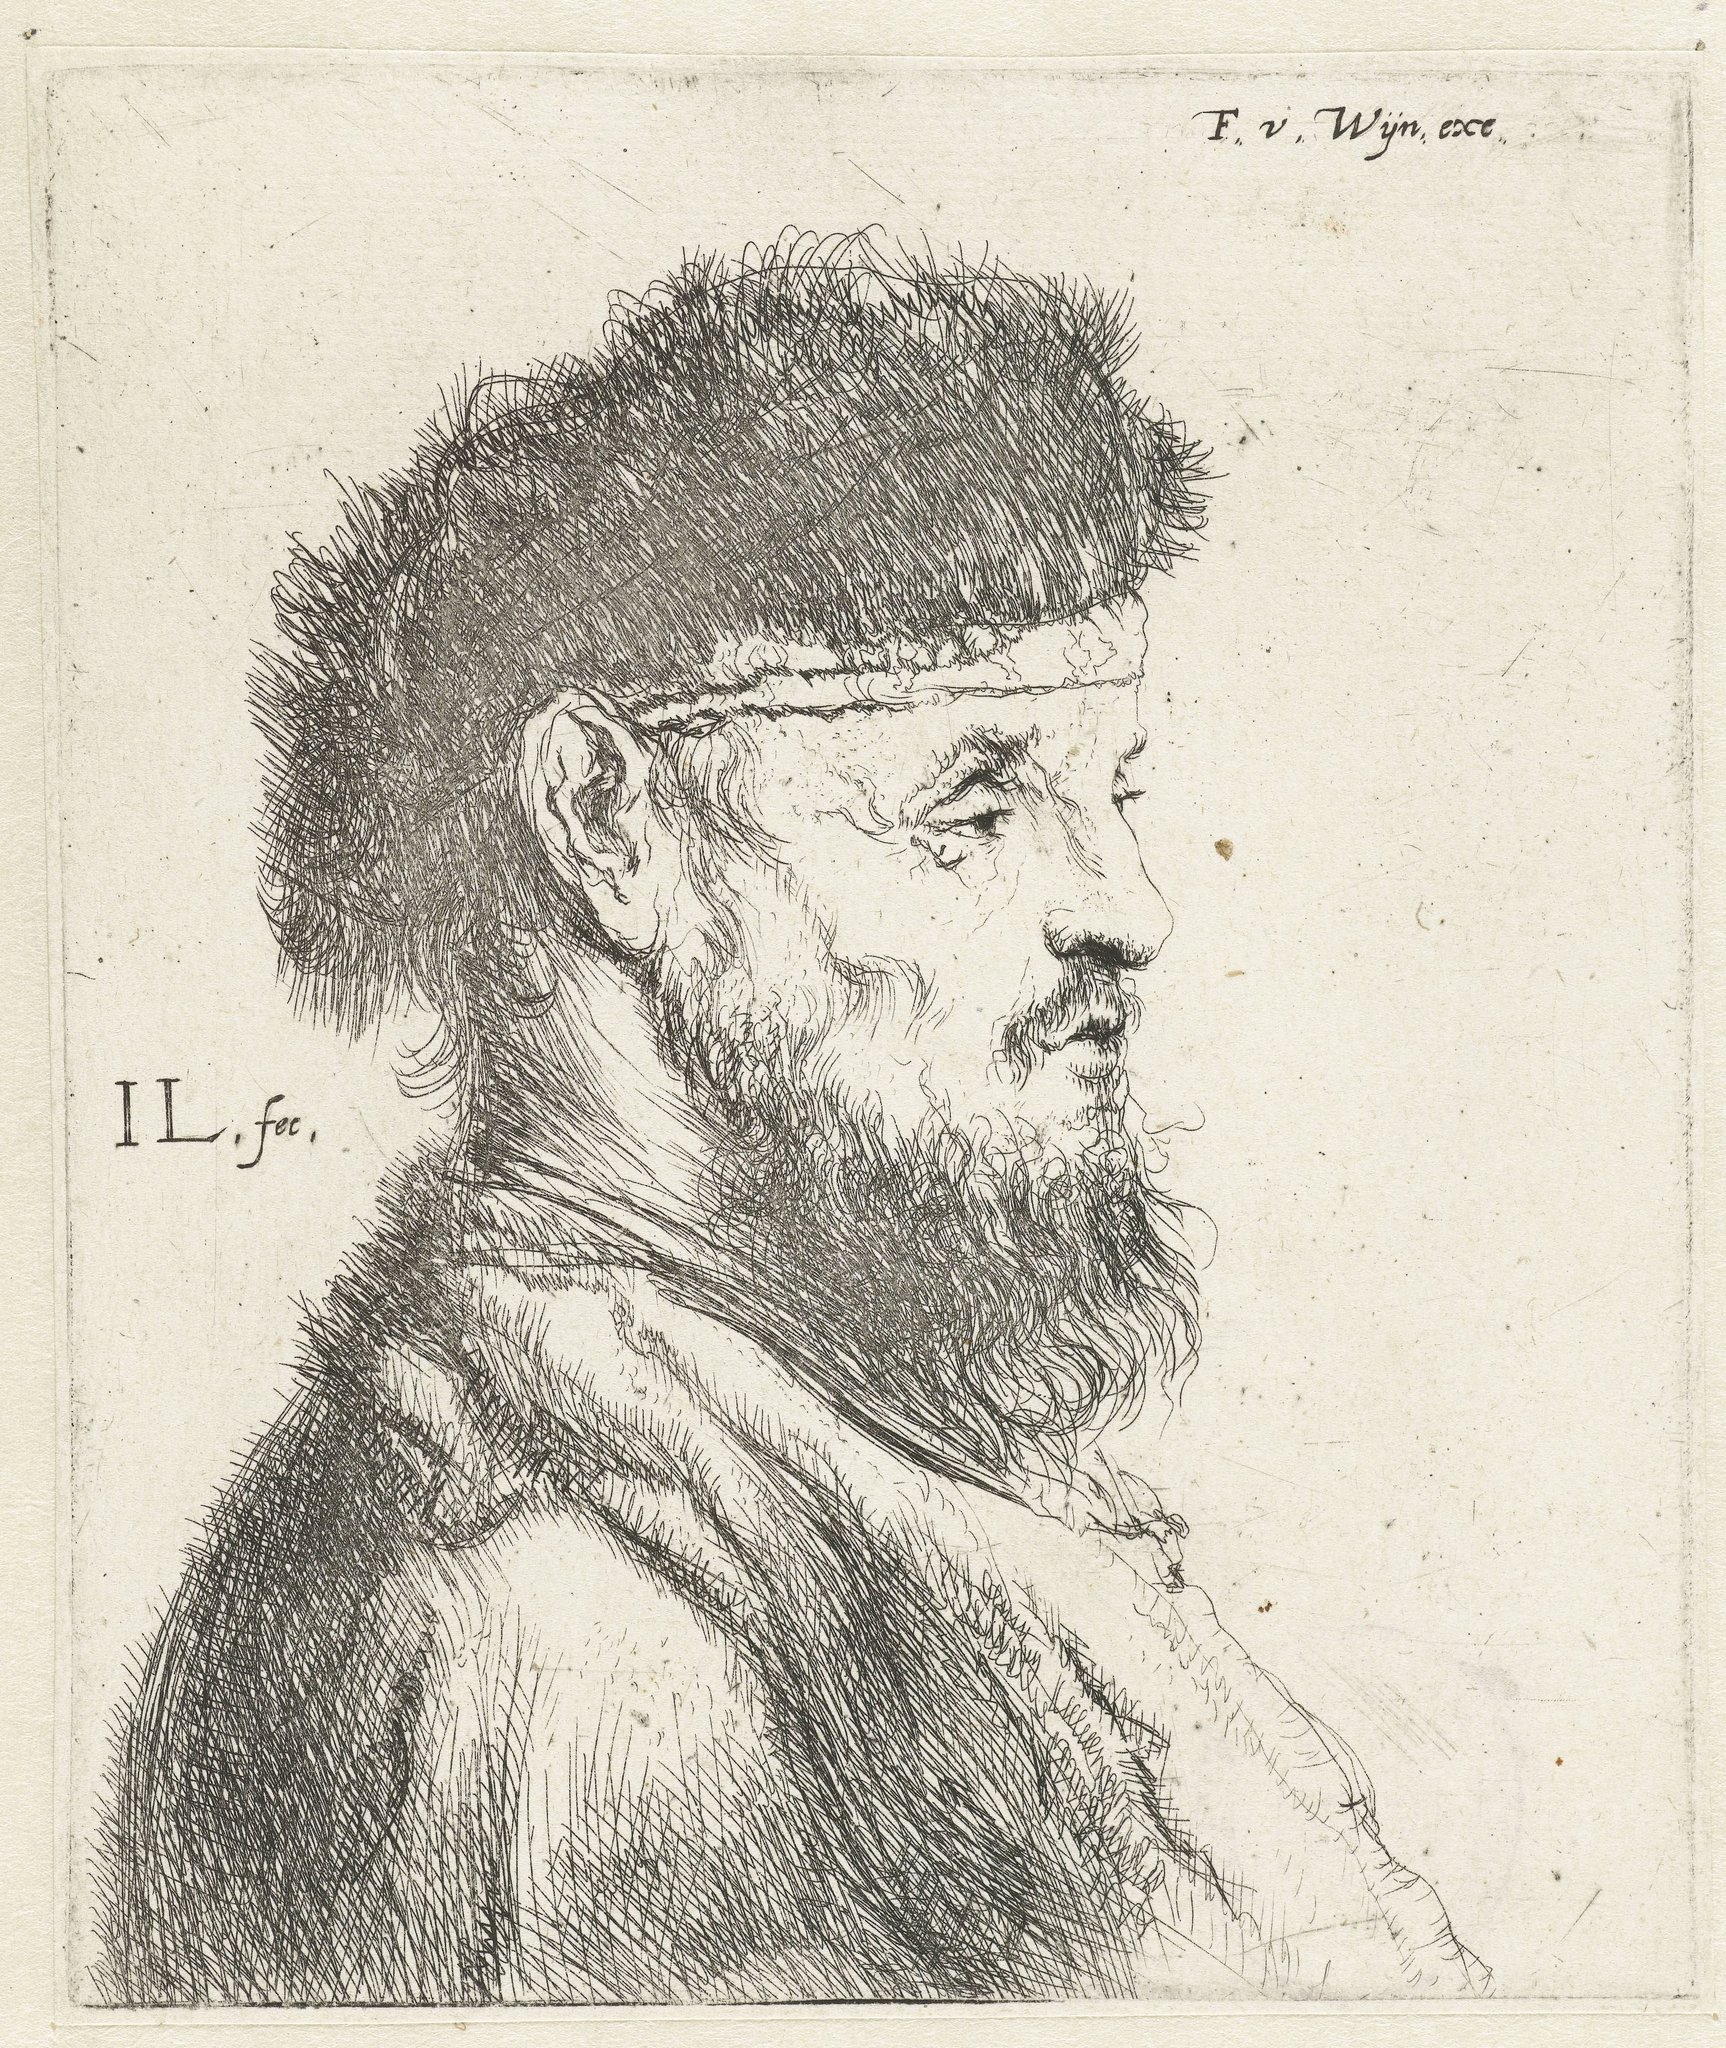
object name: print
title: Borstbeeld van een man met baard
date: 1625-1674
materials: paper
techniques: etching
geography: antwerp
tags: adult man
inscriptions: collector's mark: Lugt 240